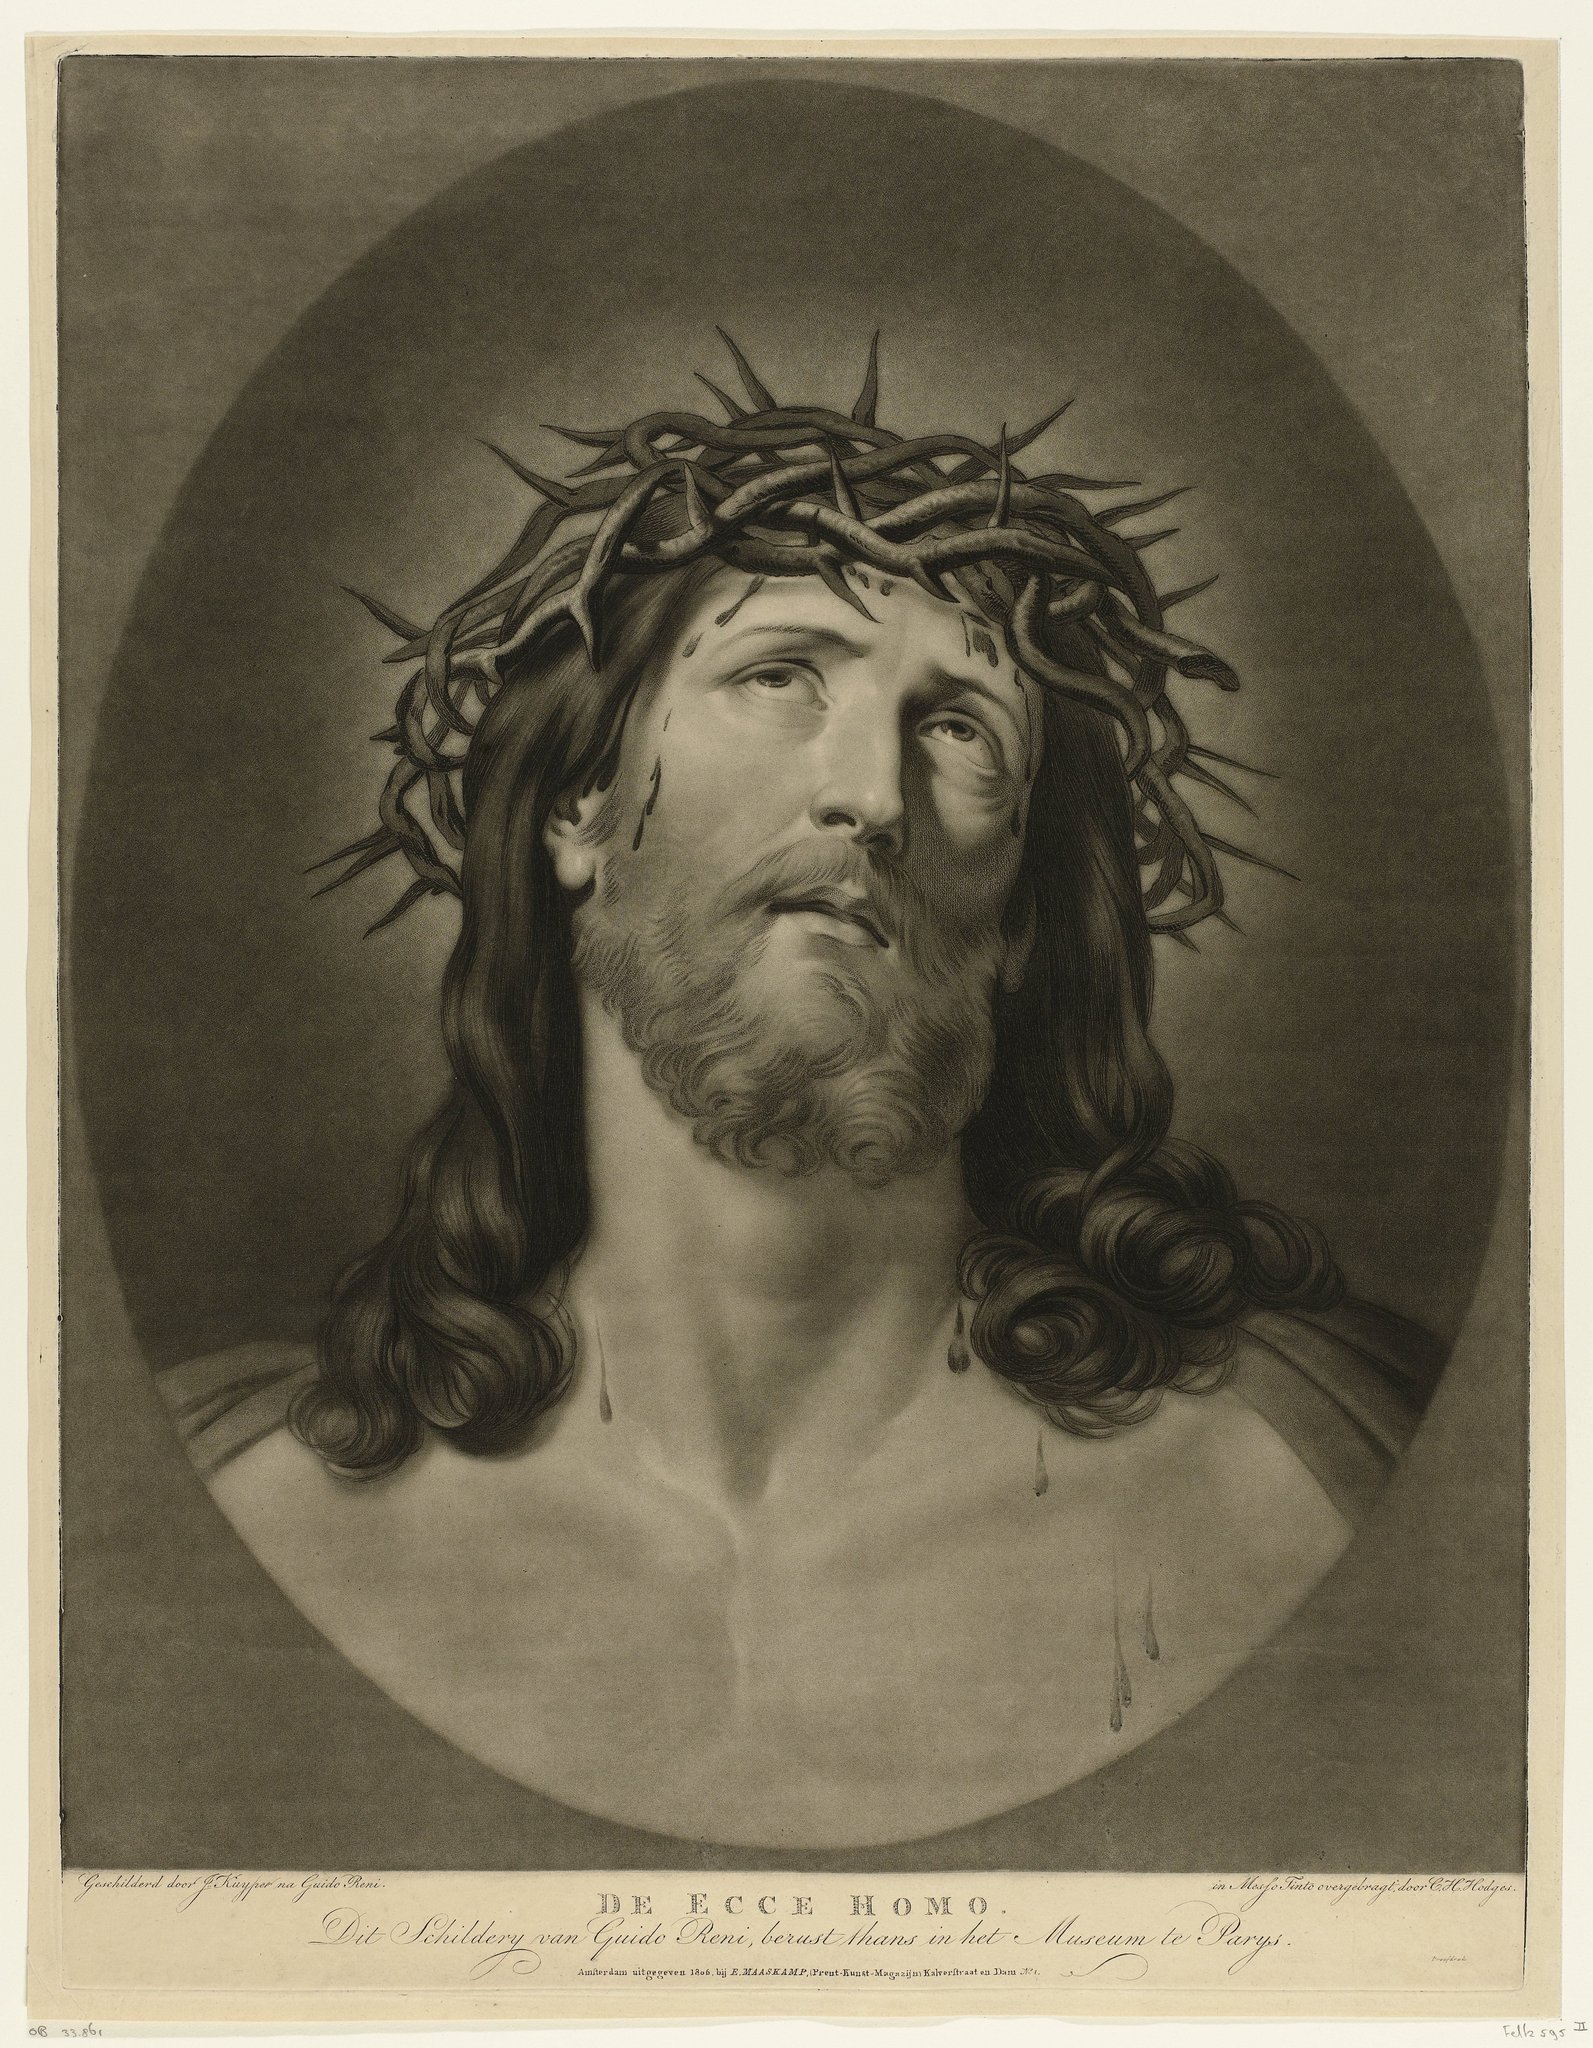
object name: print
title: Ecce Homo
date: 1806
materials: paper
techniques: etching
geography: amsterdam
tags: christ alone (also called 'ecce homo')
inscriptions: collector's mark: Lugt 2228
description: Christus met de doornenkroon en een mantel. (Joh. 19.5).